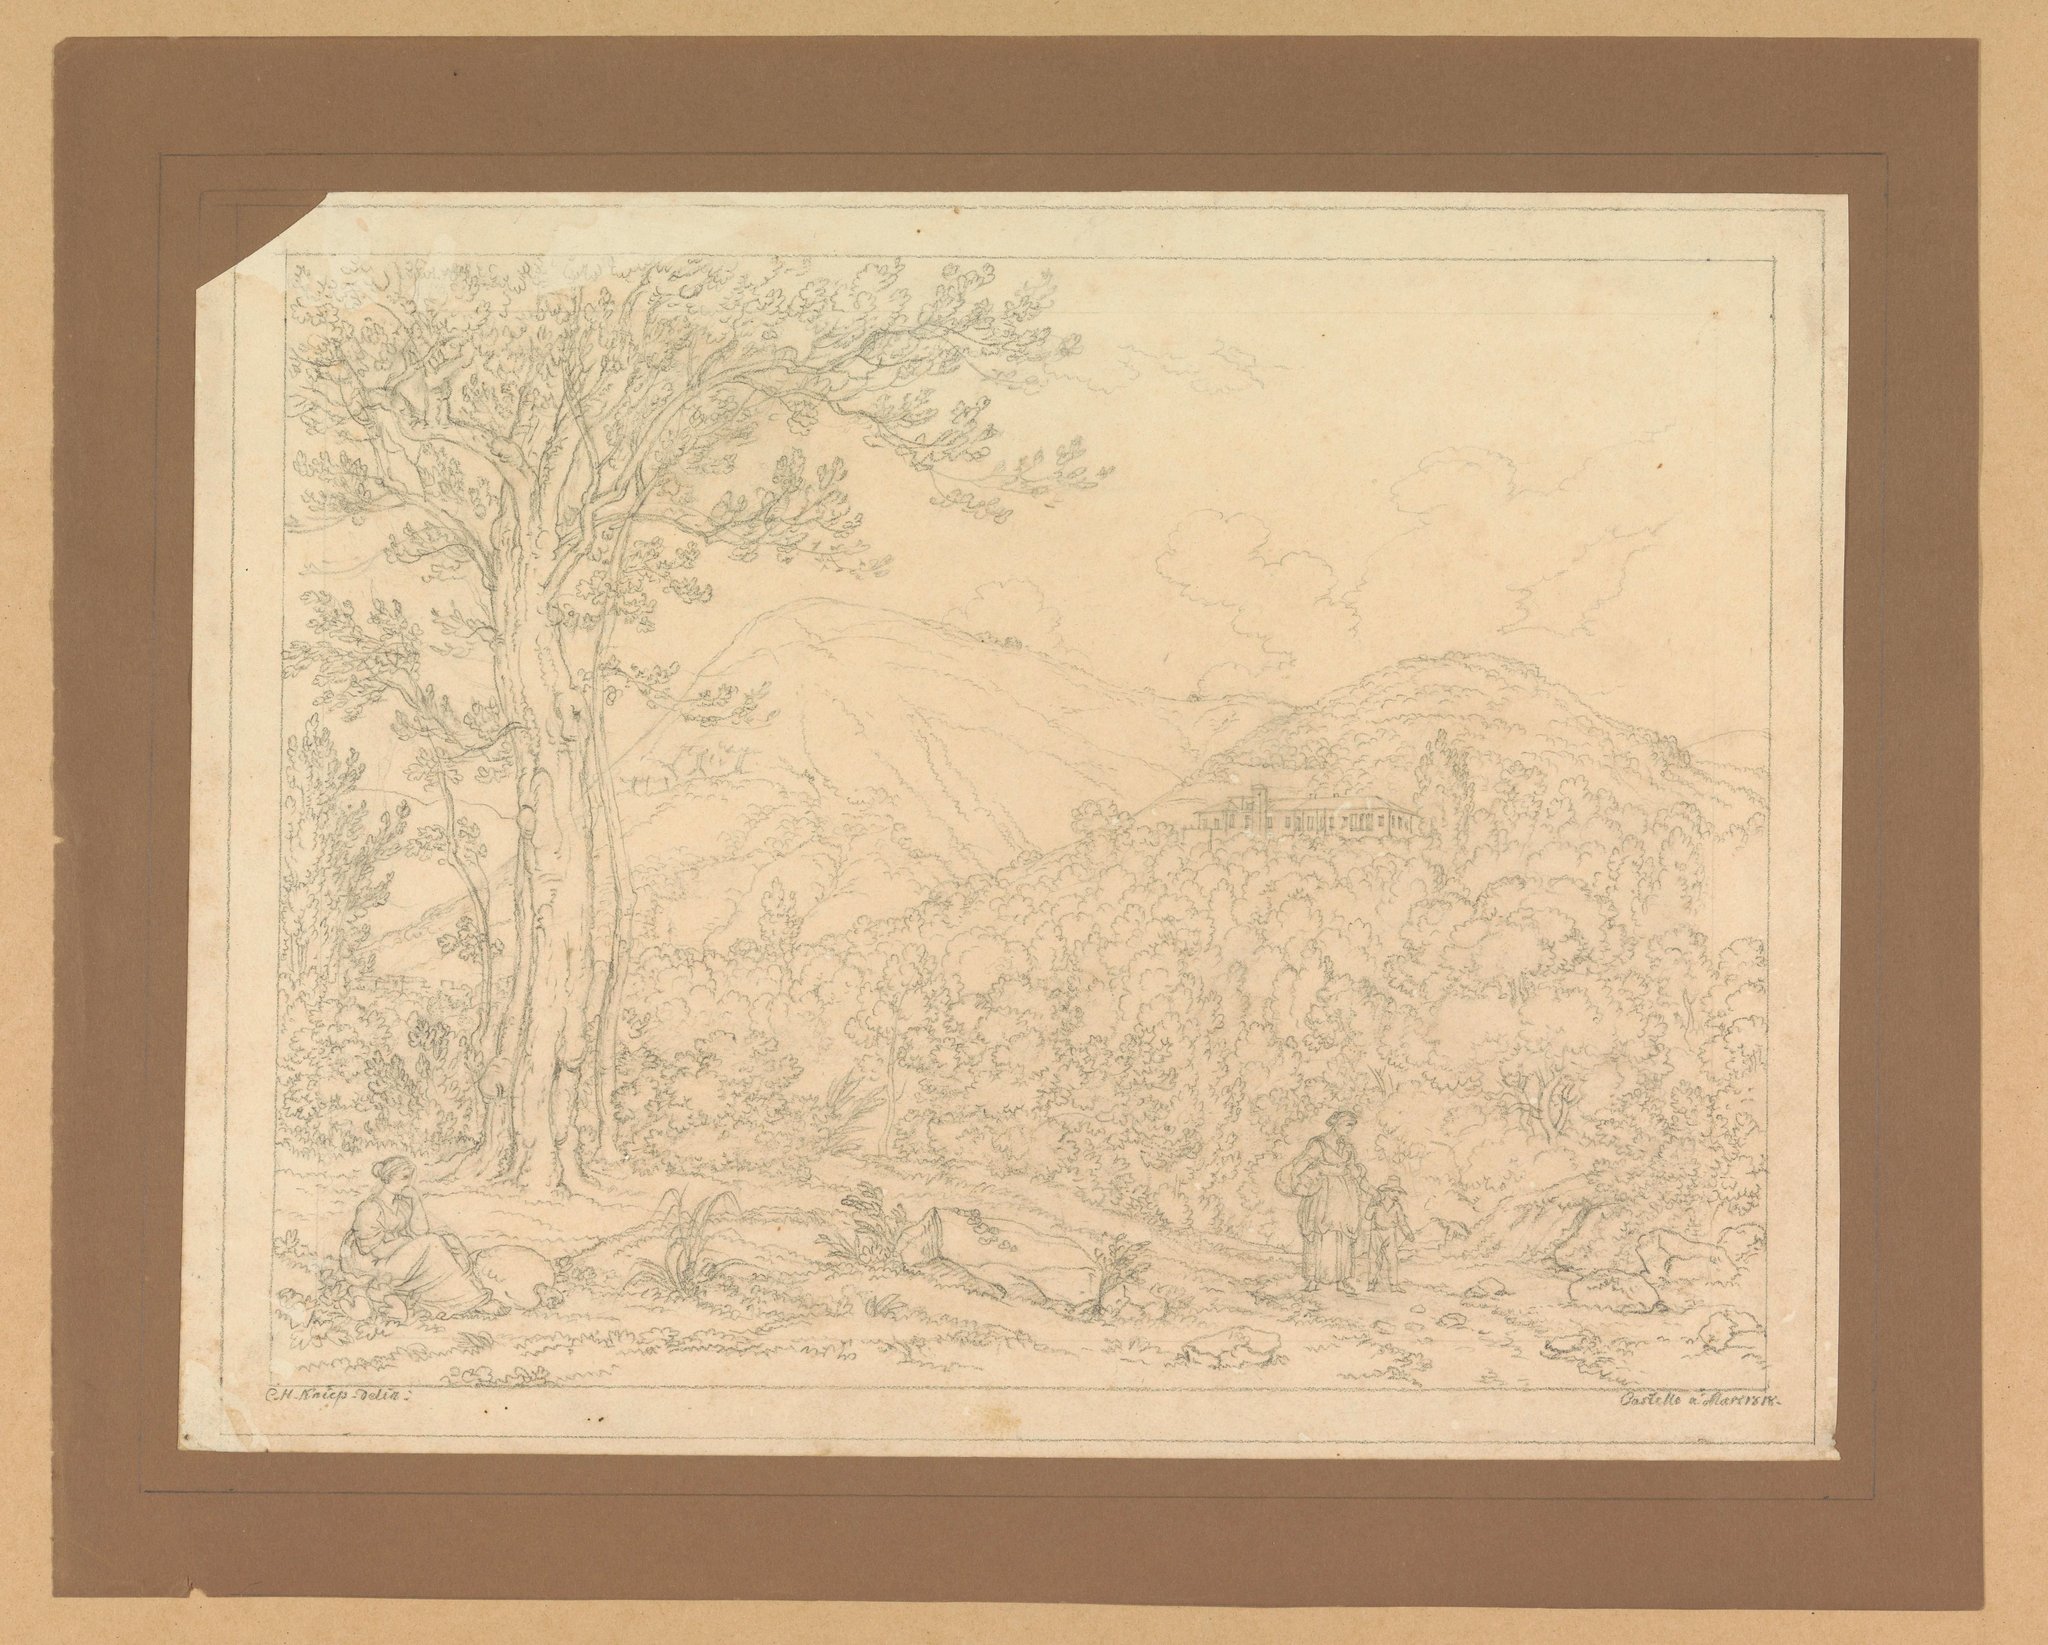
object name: drawing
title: Berglandschap bij Castello al Mare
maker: christoph heinrich kniep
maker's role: draughtsman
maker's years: 1755-1825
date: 1818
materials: paper, pencil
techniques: brush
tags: mountains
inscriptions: inscription: ‘Castello al Mare 1818.’, collector's mark: Lugt 2228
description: Met in de verte een gebouw en op de voorgrond links een zittende vrouw en rechts een vrouw met kind.